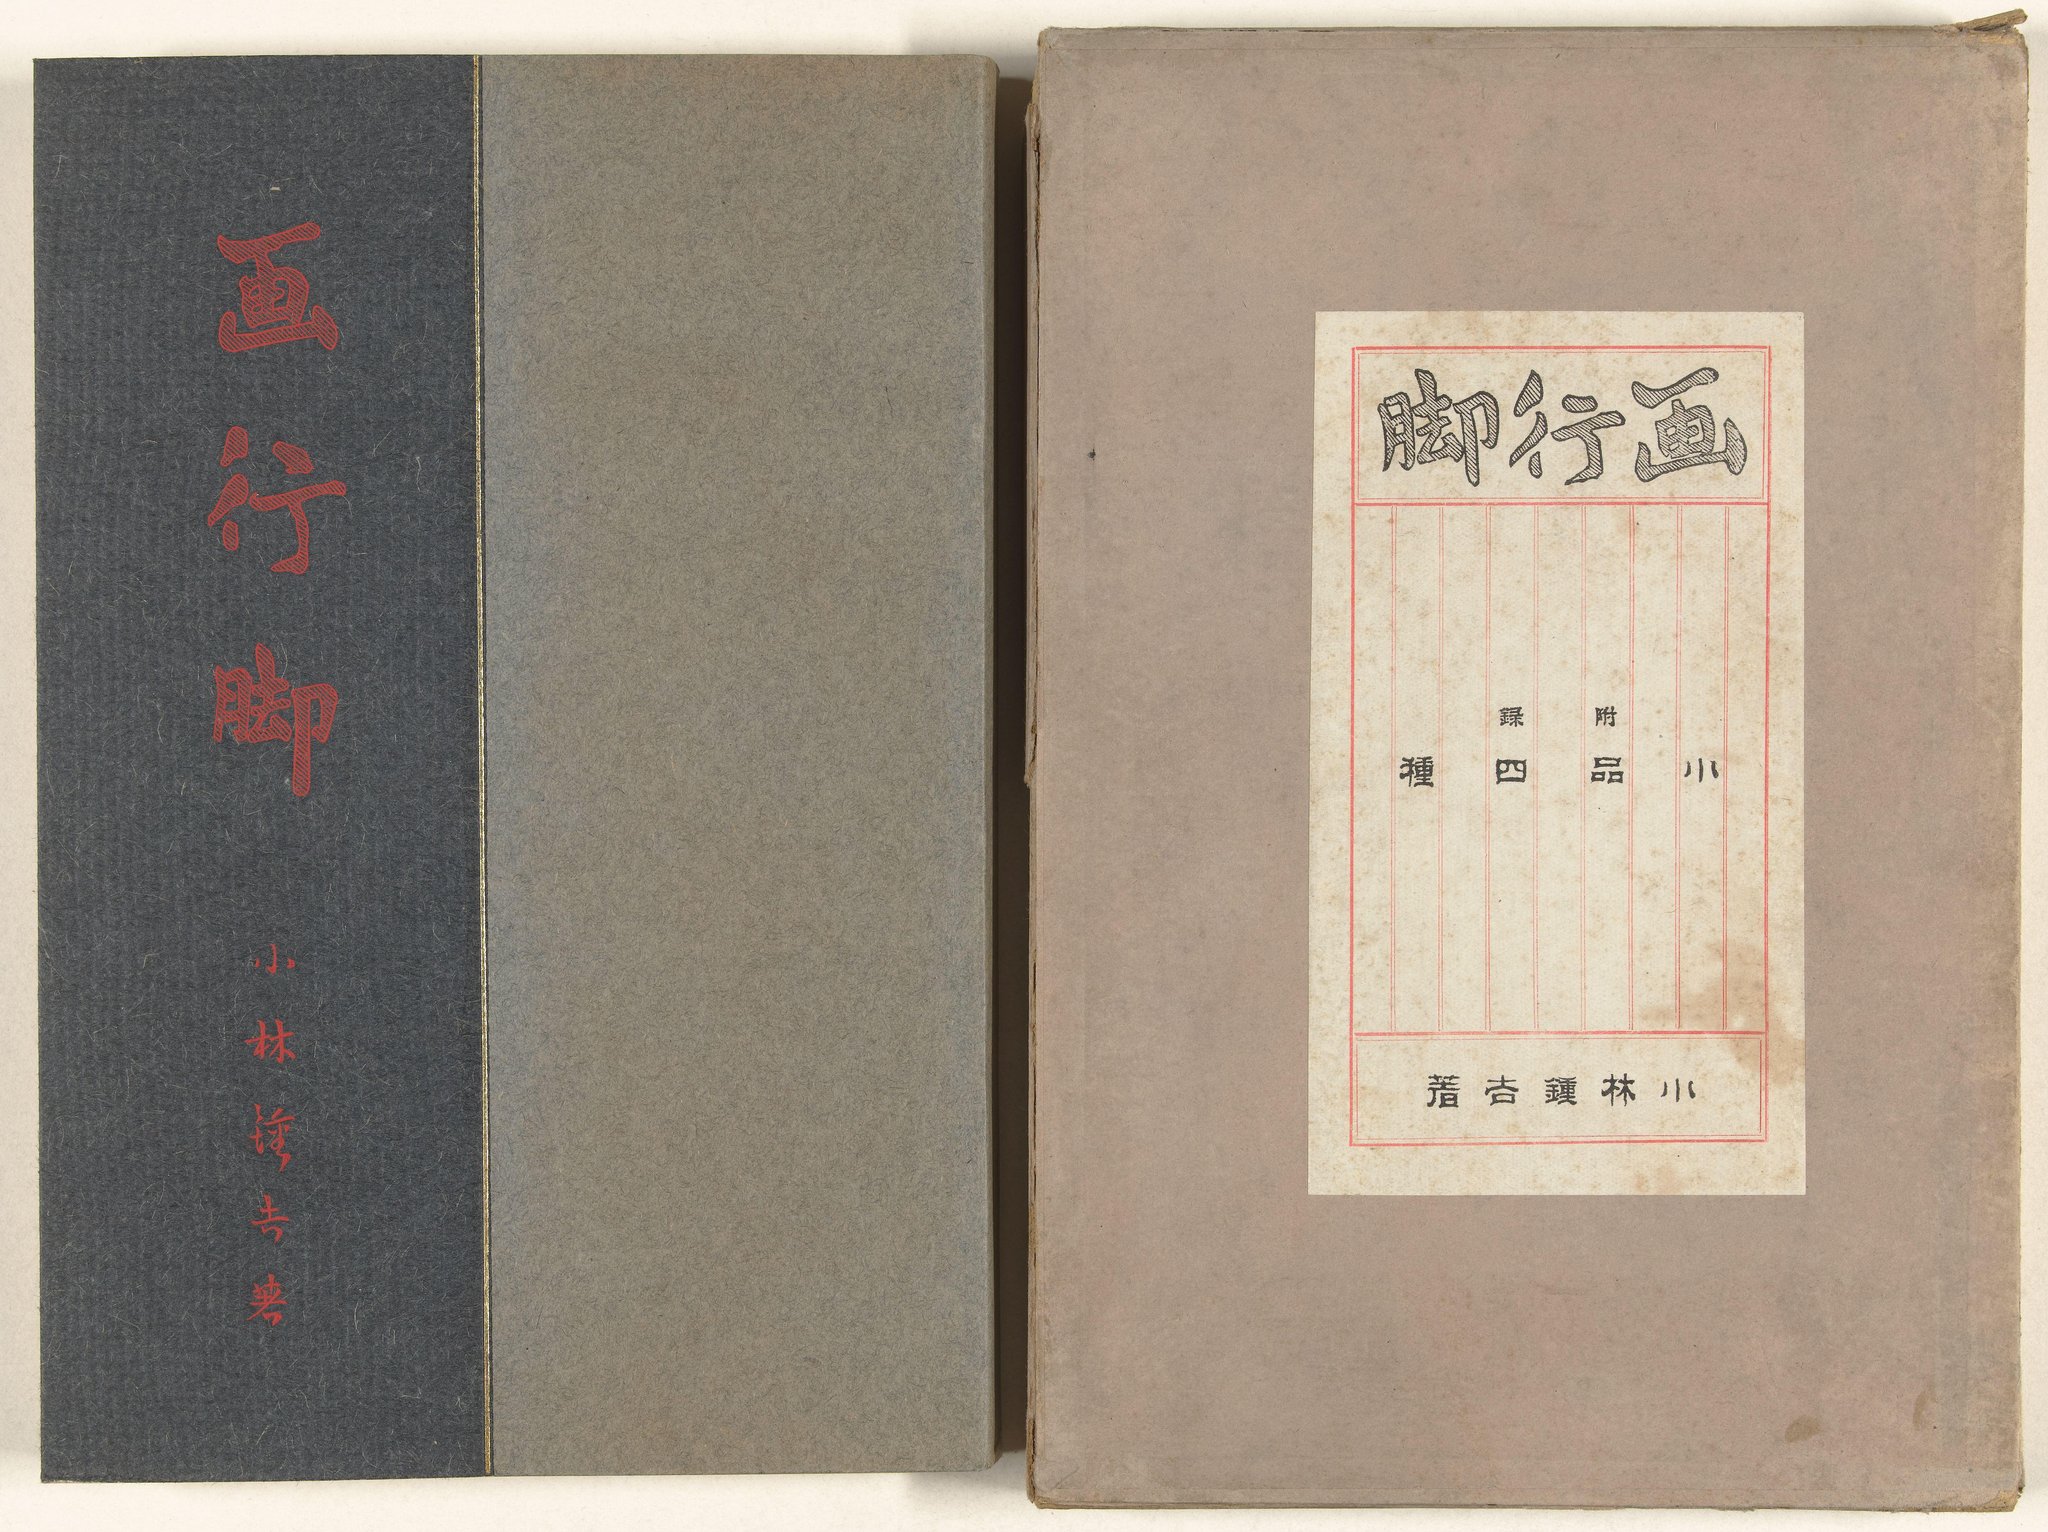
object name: book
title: Ga angya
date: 1903-1910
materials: paper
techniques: woodcut, letterpress printing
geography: japan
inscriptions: date